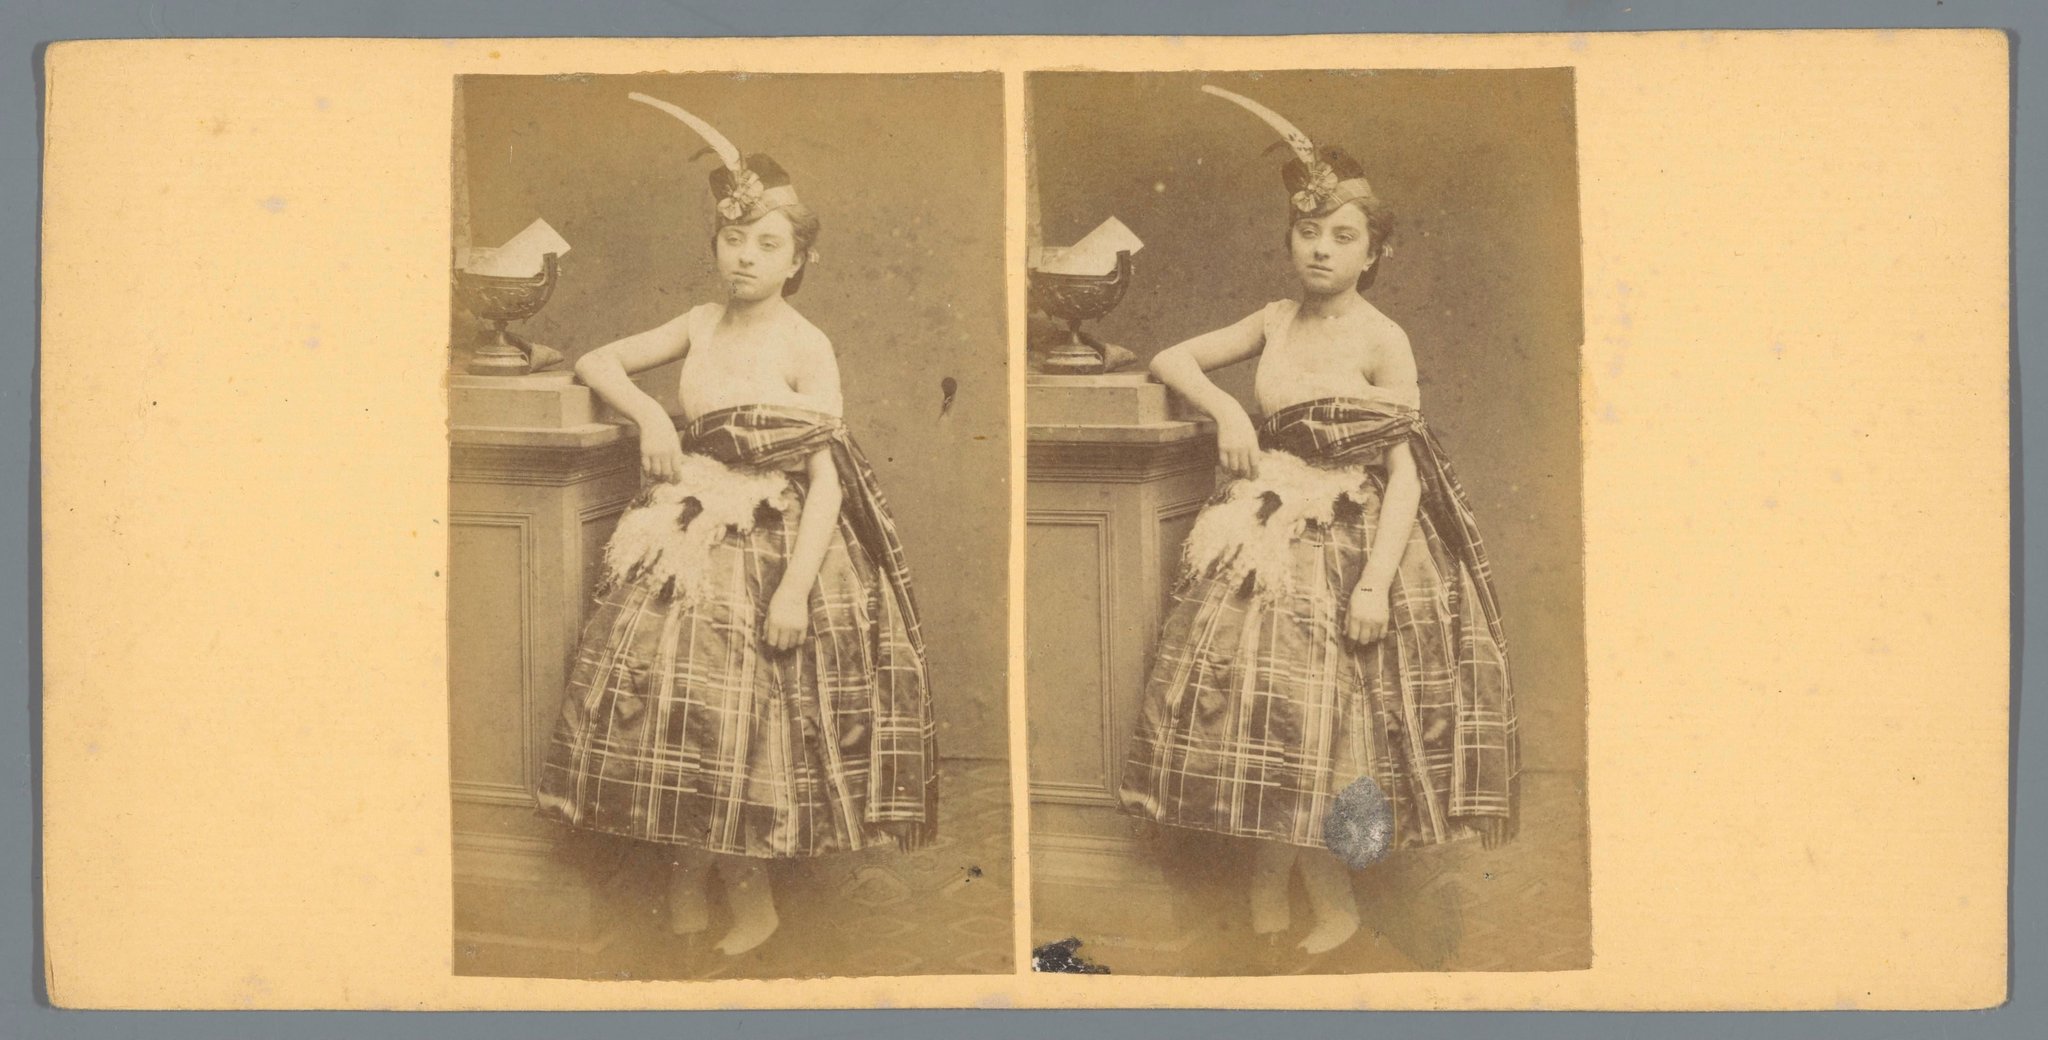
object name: stereograph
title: Portret van een vrouw met een ontblote schouder en een hoed met een veer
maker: Anonymous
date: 1850-1880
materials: cardboard, photographic support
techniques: albumen print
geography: europe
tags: head-gear: hat, europe